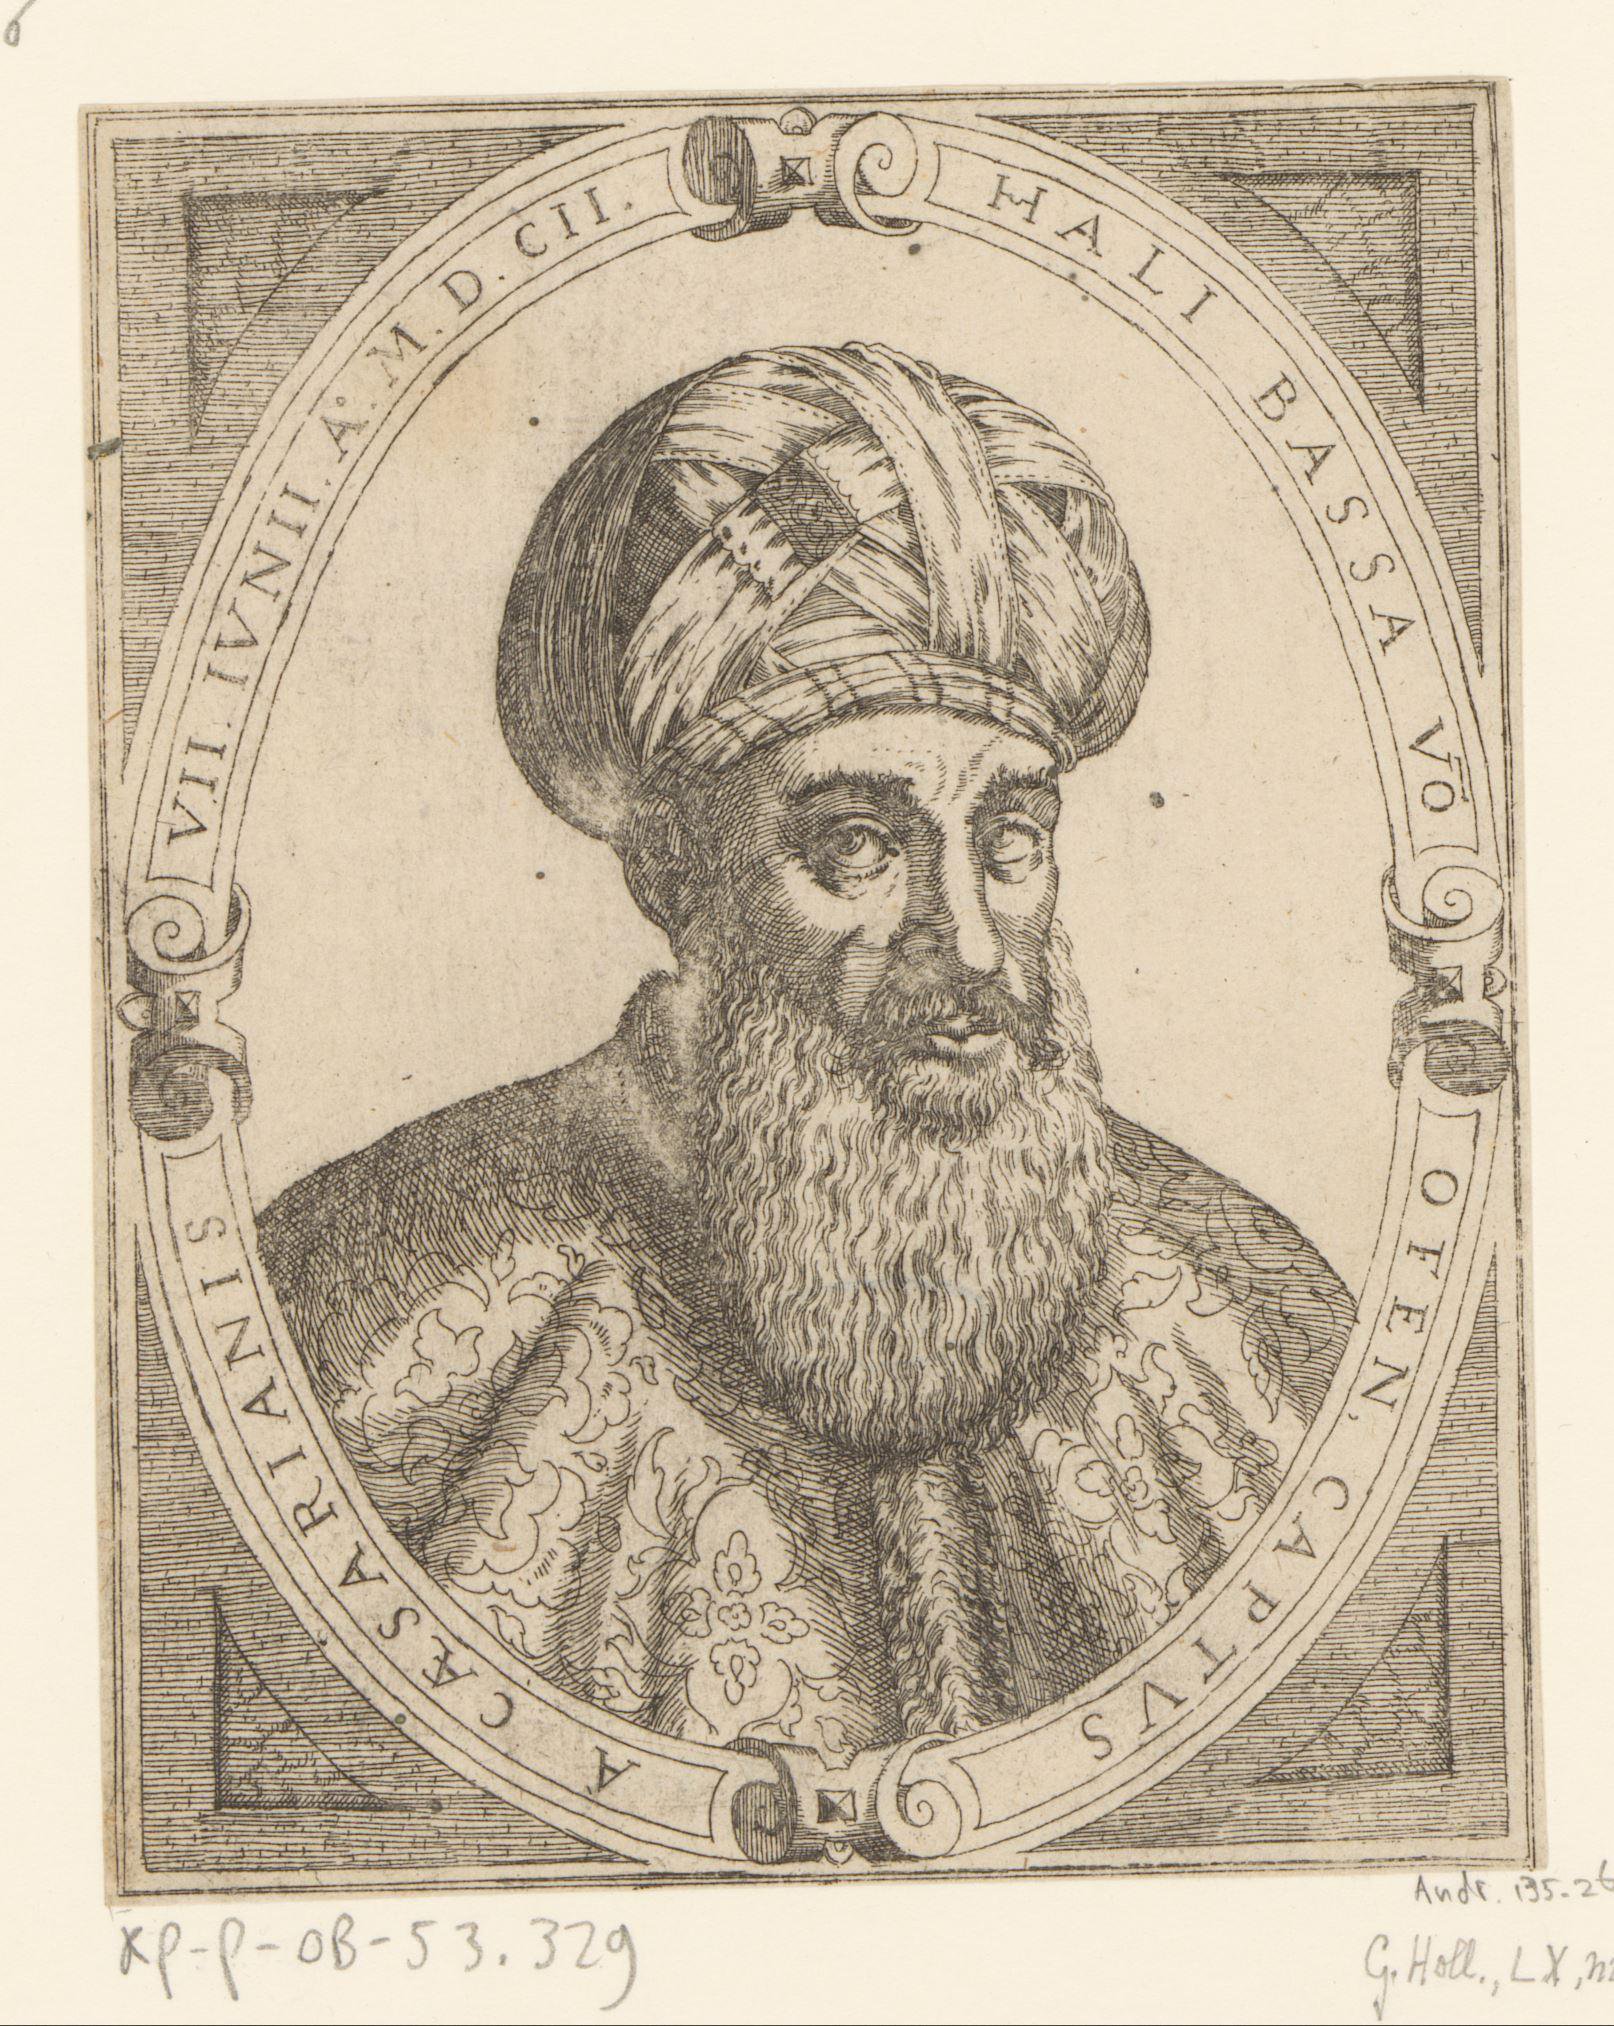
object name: print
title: Portret van Hali Pascha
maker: hans sibmacher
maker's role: print maker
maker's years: -1611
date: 1590-1611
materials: paper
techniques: etching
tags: historical persons, head-gear: turban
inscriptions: collector's mark: Lugt 2228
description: Prent ook gebruikt in: Oretlius, Hieronymus. Chronologica (...). Neurenberg: Valentin Fuhrmann et. al., 1602-1665.